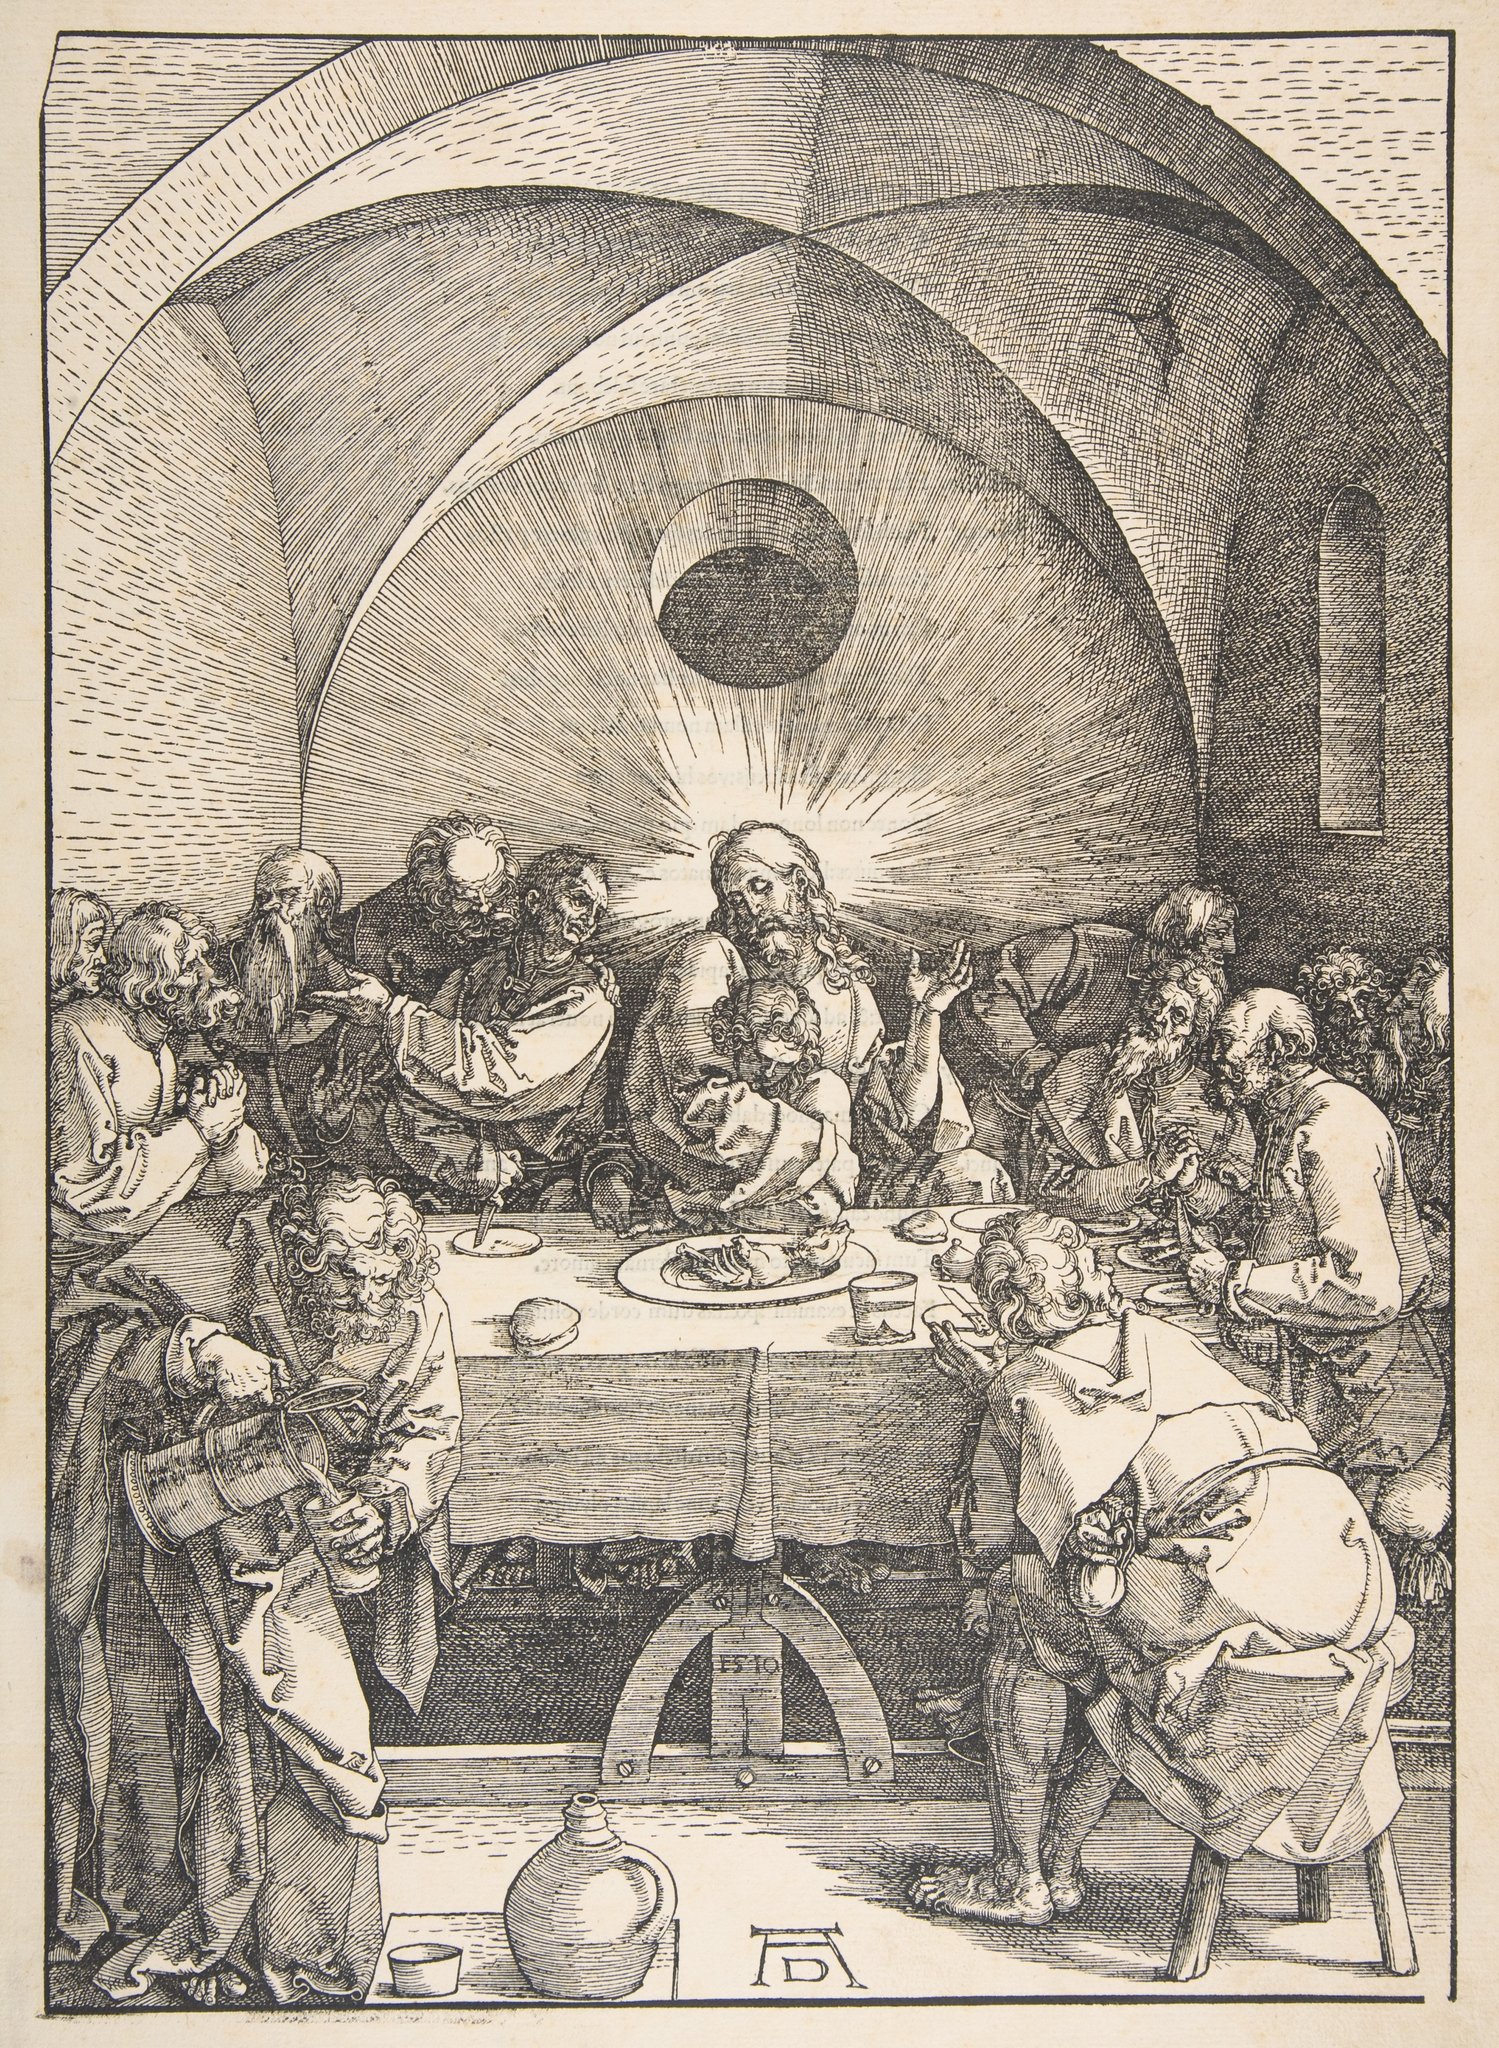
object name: print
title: The Last Supper, from "The Large Passion"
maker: albrecht dürer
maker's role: artist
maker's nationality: german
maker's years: 1471-1528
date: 1511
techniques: woodcut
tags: men,christ,last supper